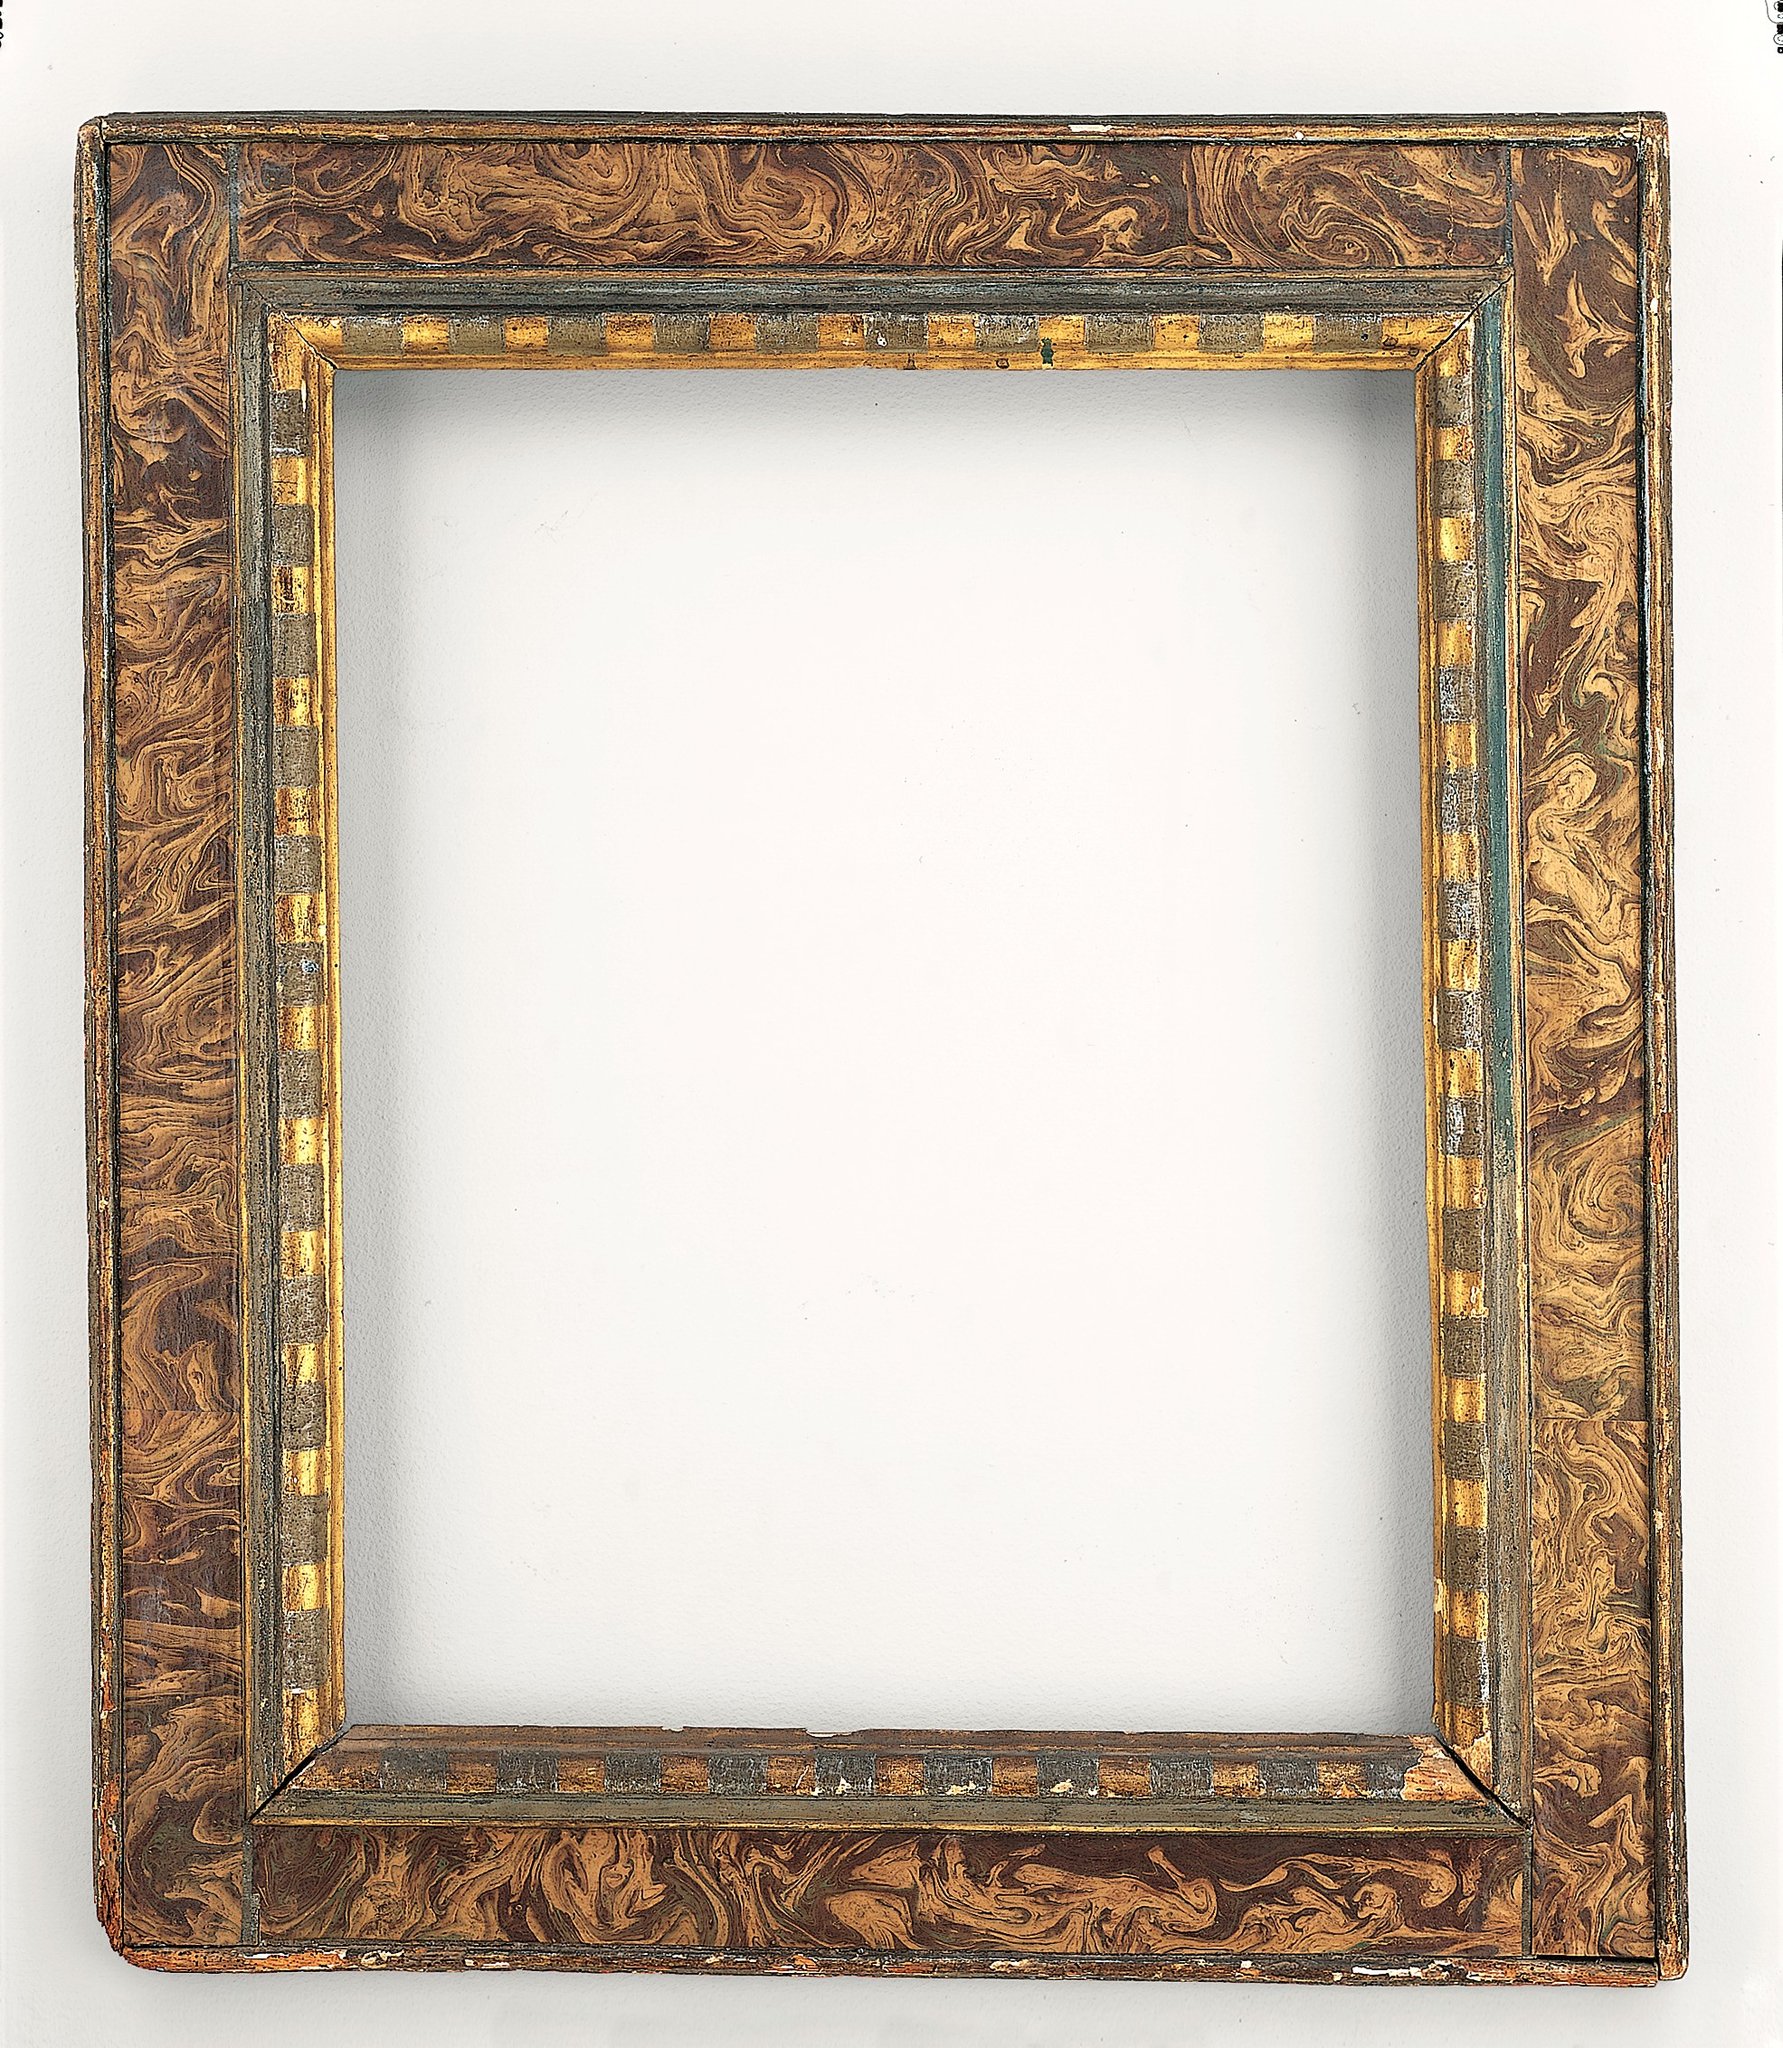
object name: frame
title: Reverse cassetta frame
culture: italian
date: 1640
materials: wood